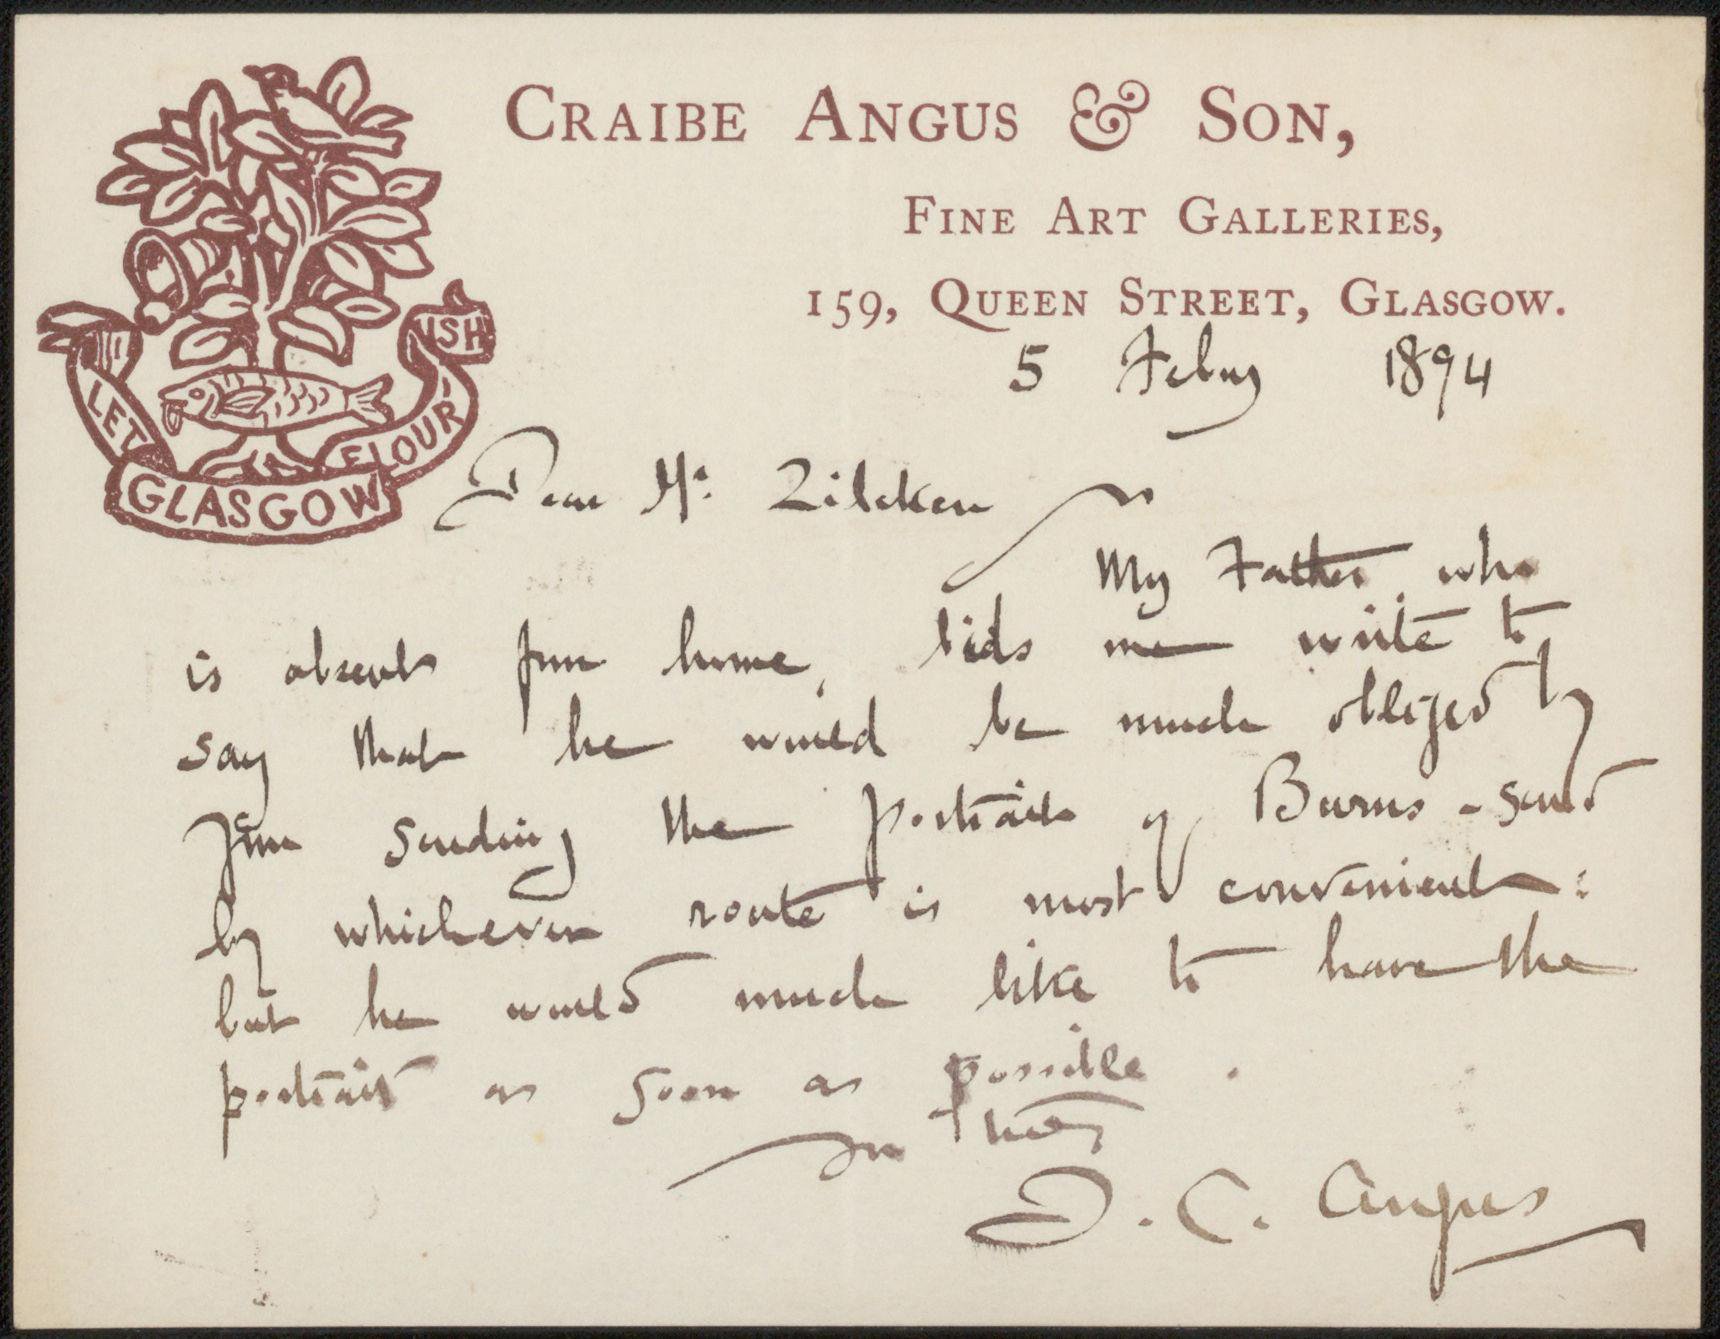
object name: letter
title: Brief aan Philip Zilcken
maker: j. craibe angus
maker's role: kunsthandelaar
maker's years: 1865-1901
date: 1894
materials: ink, paper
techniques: pen, printing, writing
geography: glasgow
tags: painter, draughtsman, philip zilcken, historical persons (portraits and scenes from the life)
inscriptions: collector's mark: ‘RPK’